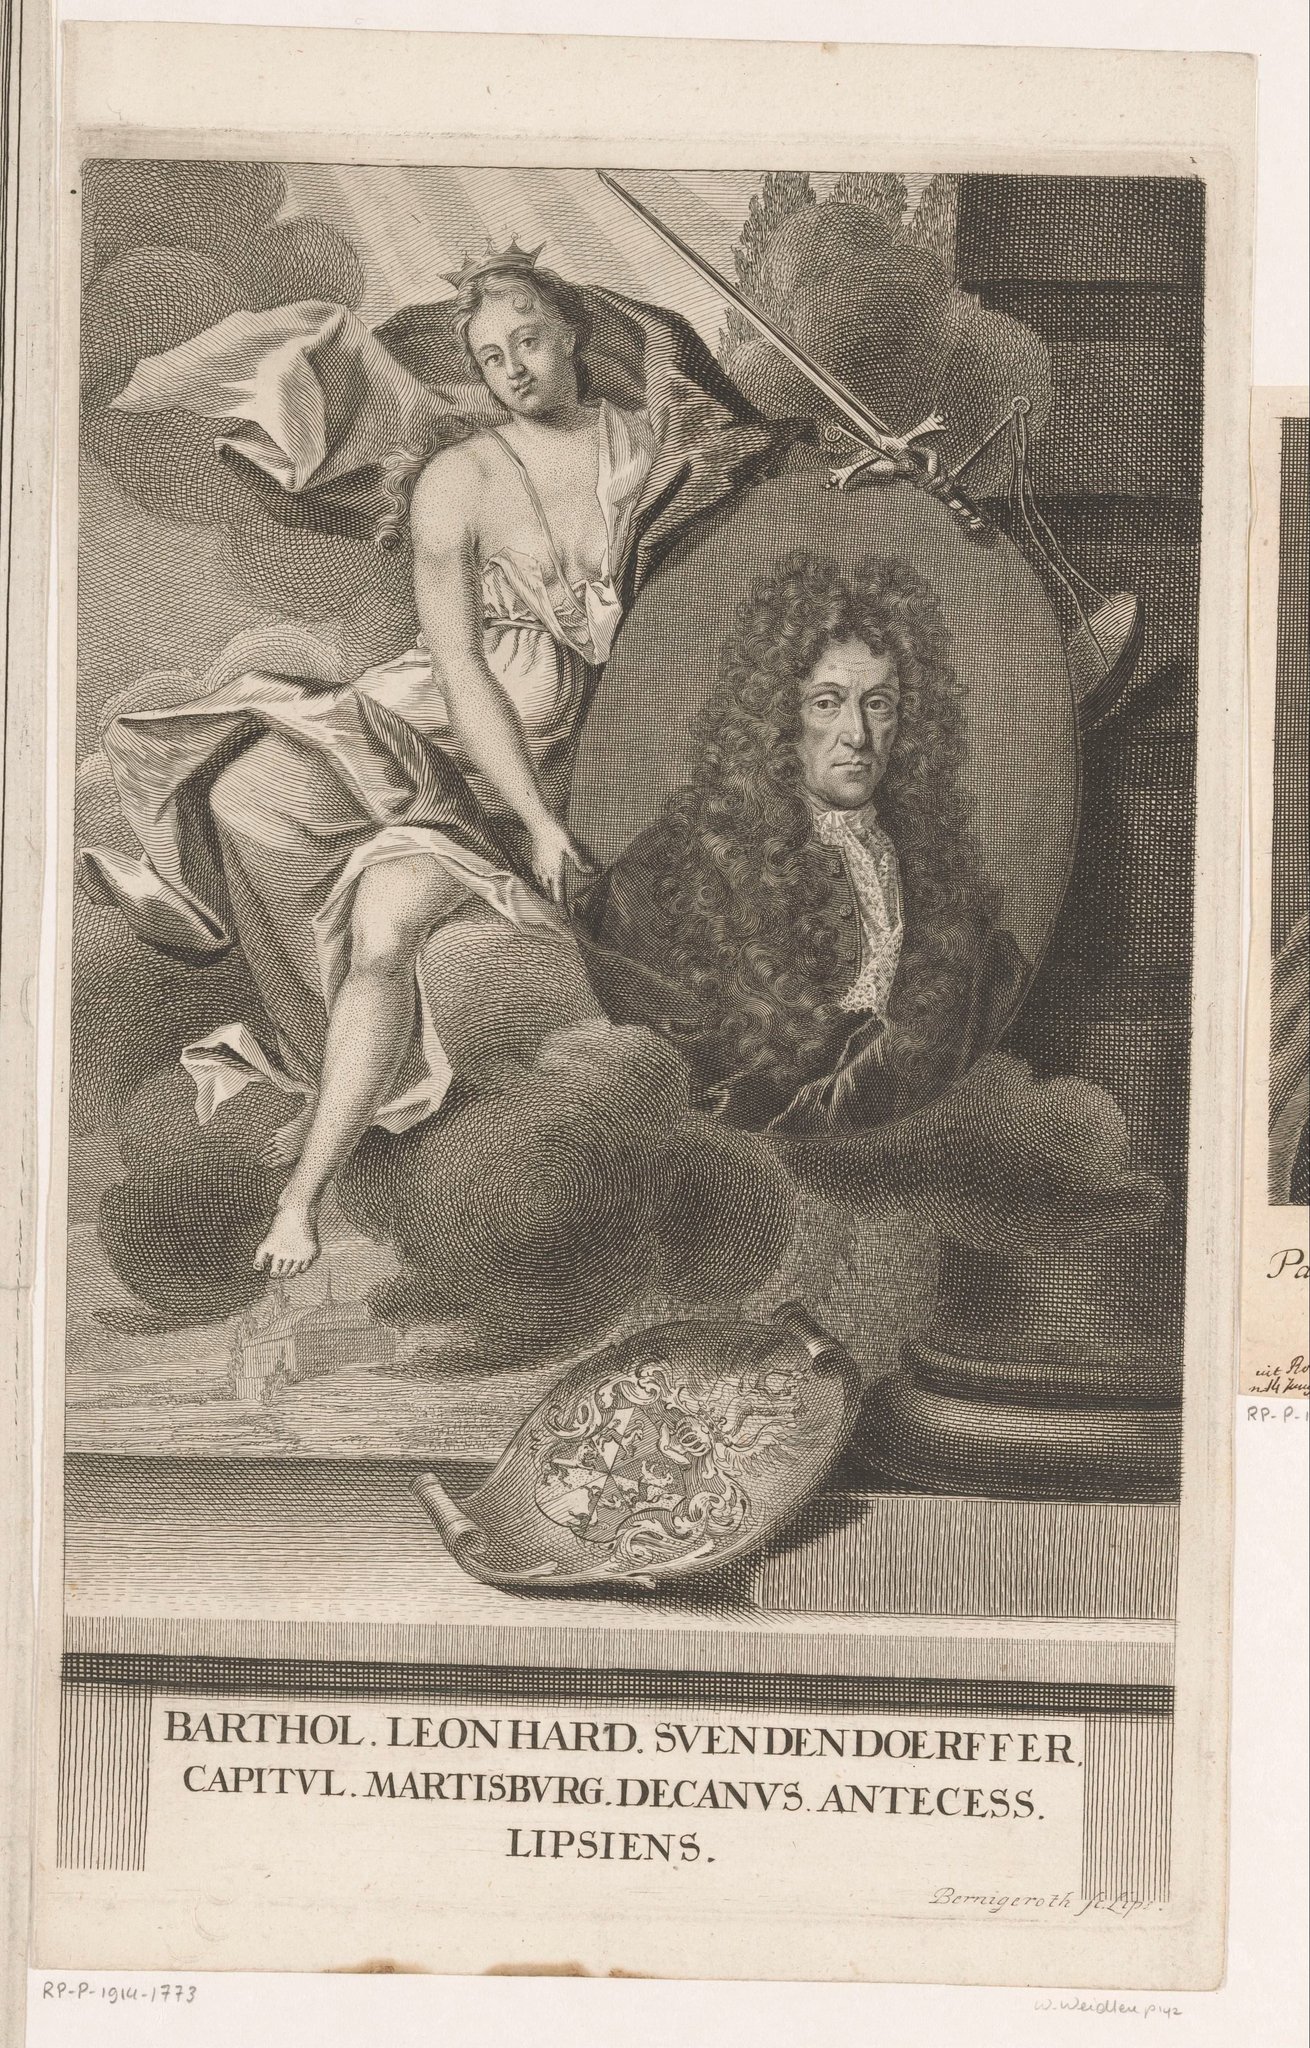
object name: print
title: Allegorisch portret van Bartholomäus Leonhard Schwendendörffer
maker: martin bernigeroth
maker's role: print maker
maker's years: 1670-1733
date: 1703-1733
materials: paper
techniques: engraving, etching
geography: leipzig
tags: historical persons, justitia (justice) as roman personification, armorial bearing, heraldry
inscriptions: collector's mark: Lugt 2228